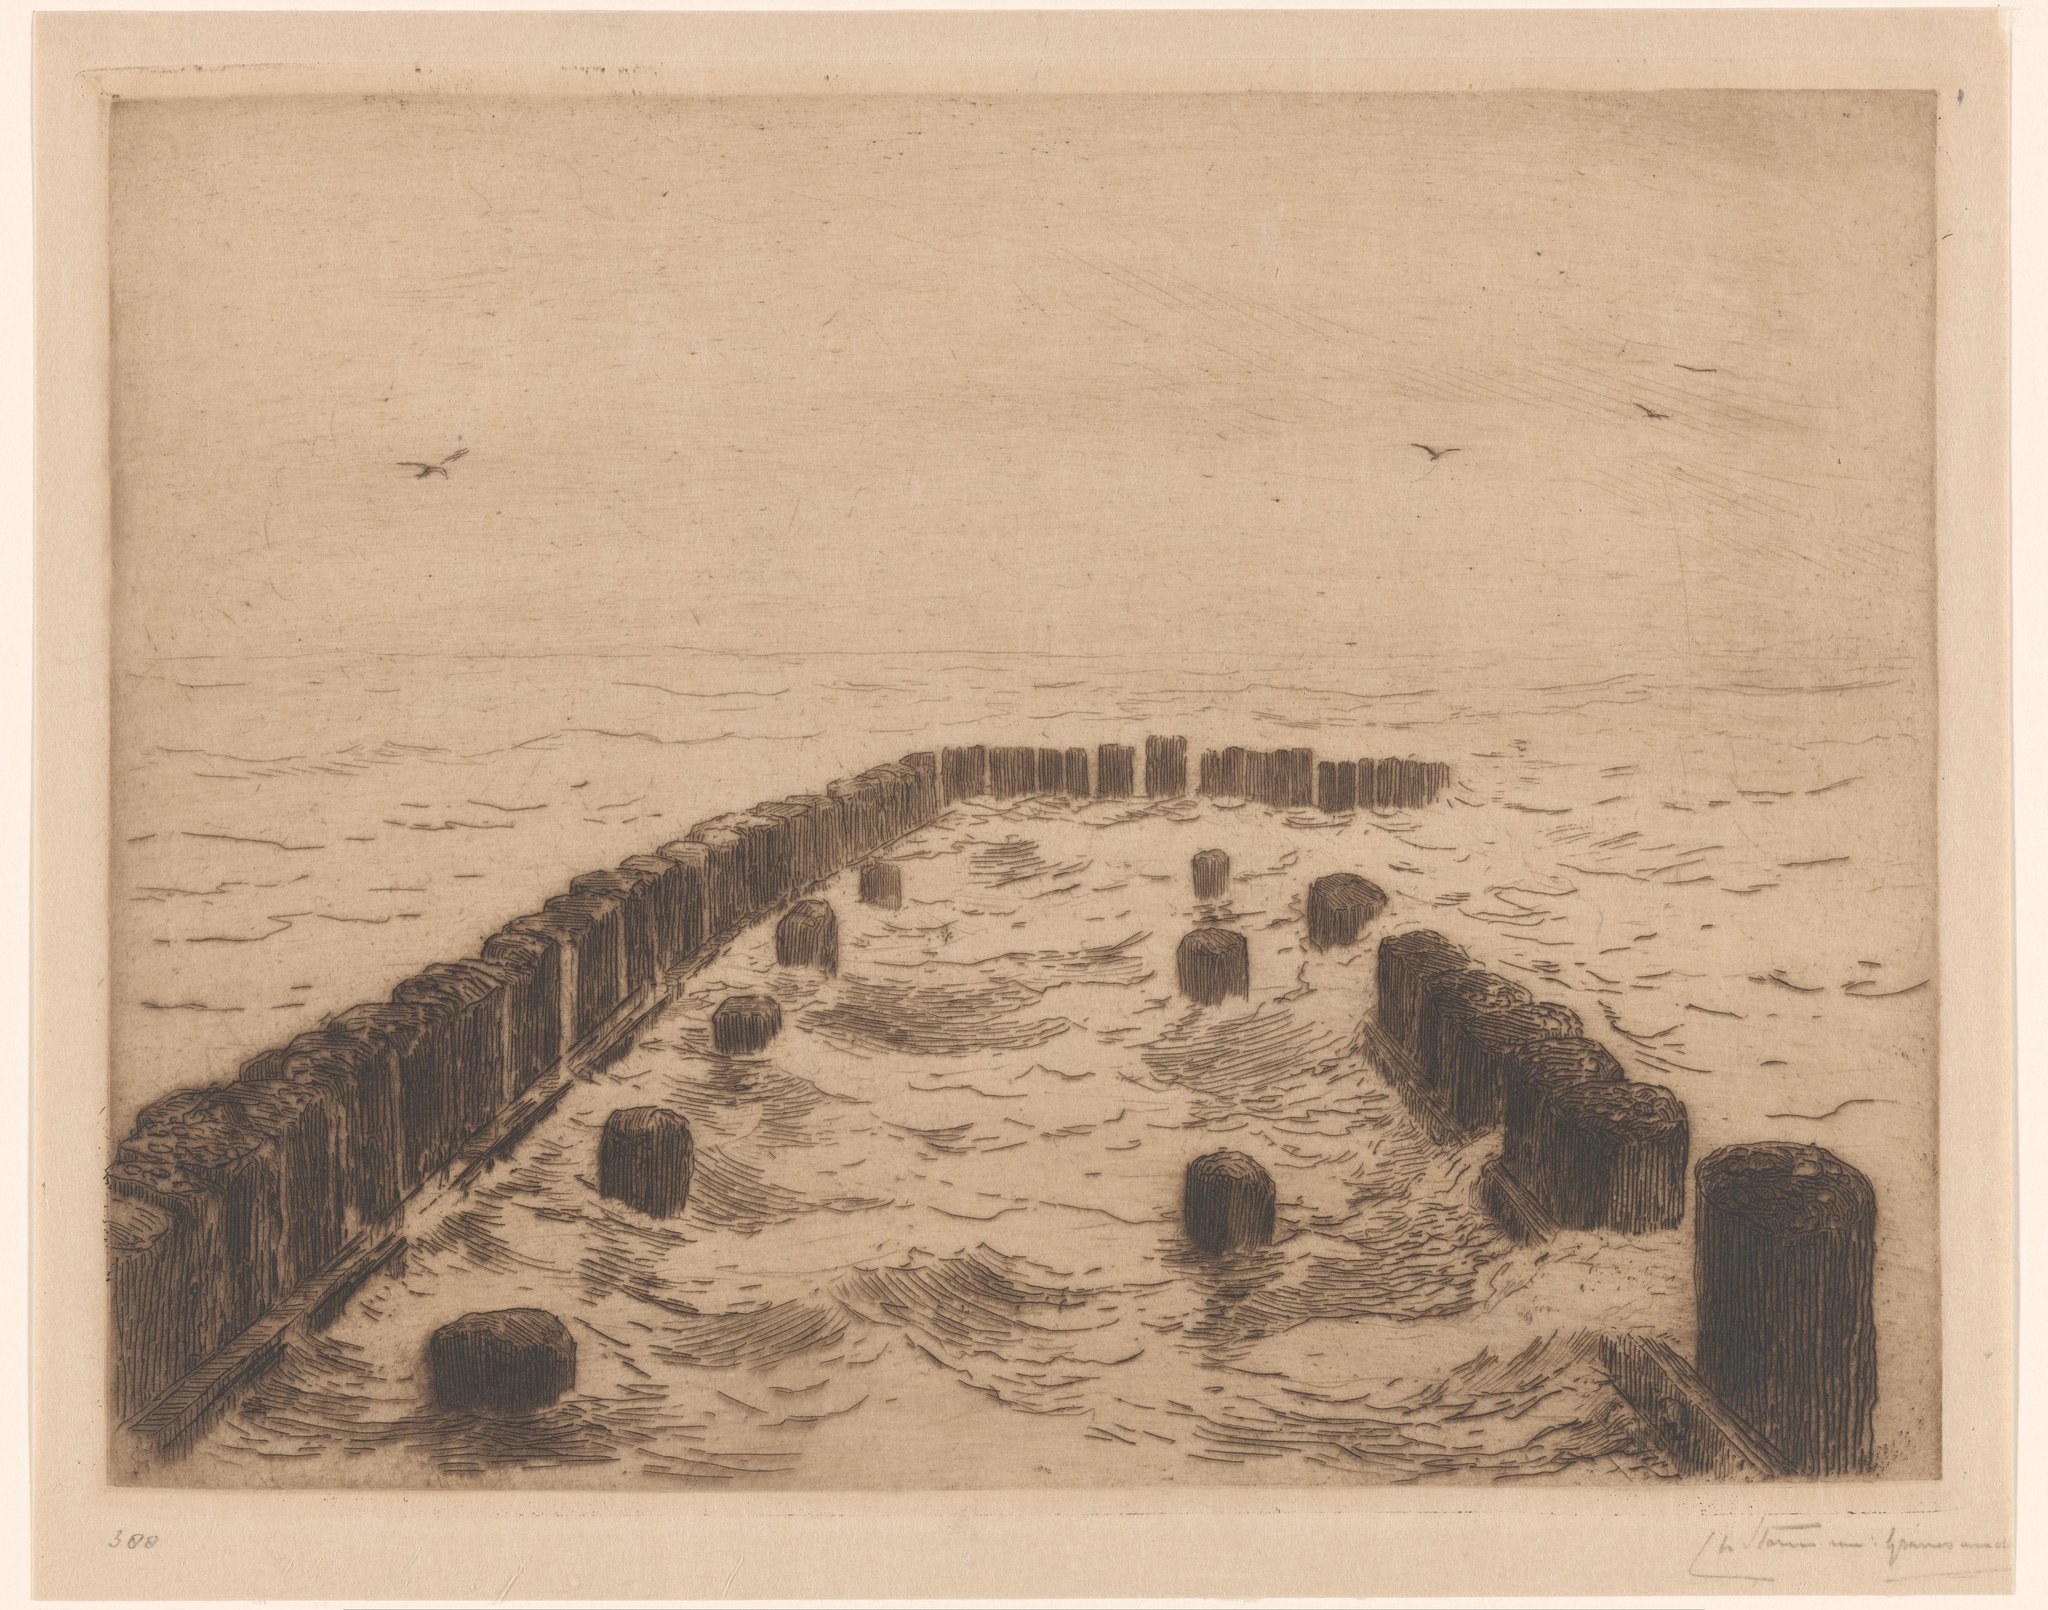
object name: print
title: Paalhoofden bij vloed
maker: carel nicolaas storm van s-gravesande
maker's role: draughtsman, print maker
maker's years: 1841-1924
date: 1851-1902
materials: paper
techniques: etching, intaglio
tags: groyne ~ breakwater, sea (seascape)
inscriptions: collector's mark: Lugt 2228, number: ‘388’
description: Mogelijk vermeld in: Storm van 's-Gravesande, Charles. Catalogue des eaux-fortes et lithographies. New York: s.n., 1903, of in een onbekende latere uitgave van het manuscript. Vermoedelijk vermeld als catalogusnummer 388.